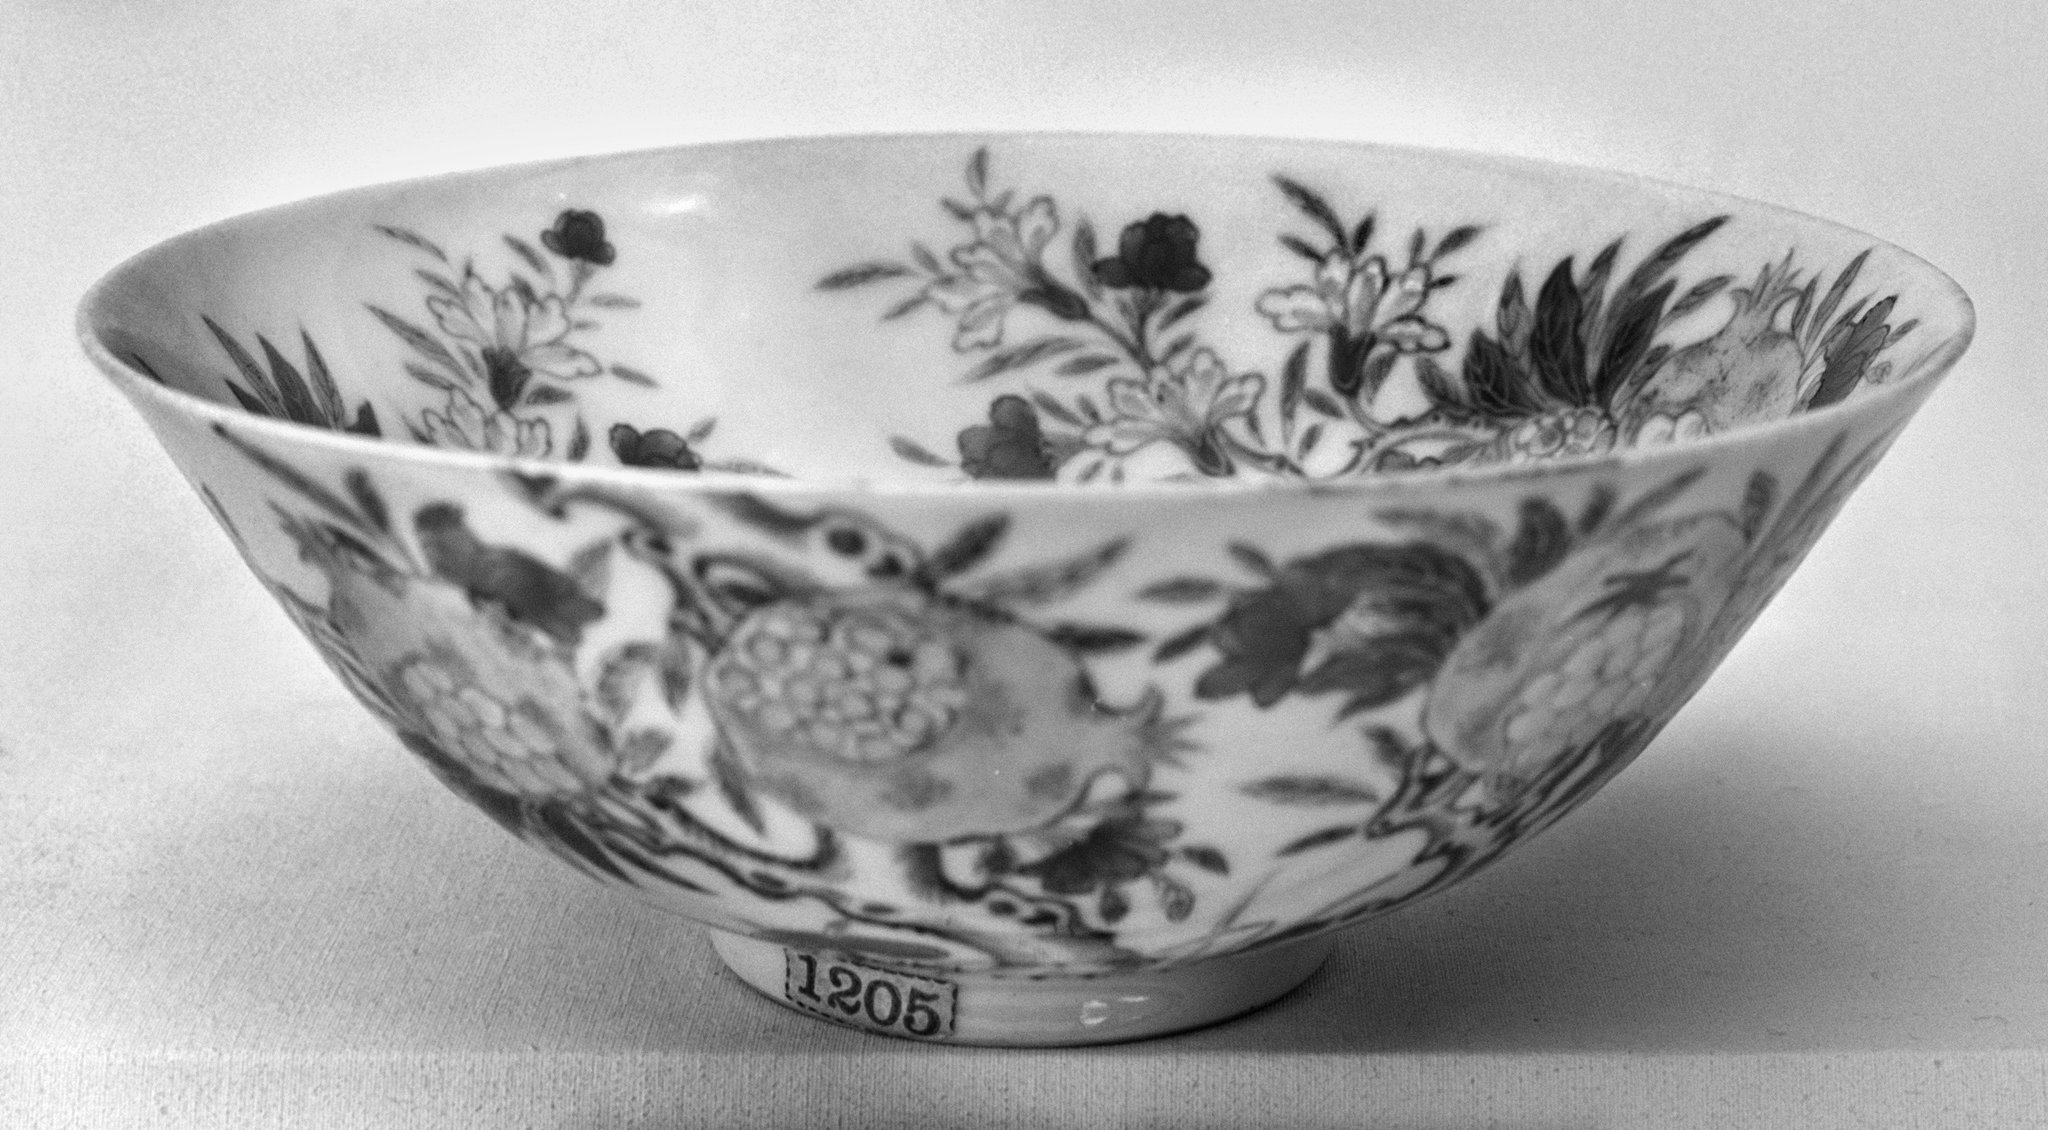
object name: bowl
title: Bowl with flowers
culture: chinese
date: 1767-1800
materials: cobalt, enamel, porcelain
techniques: overglaze, painting, polychrome, underglaze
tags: flowers